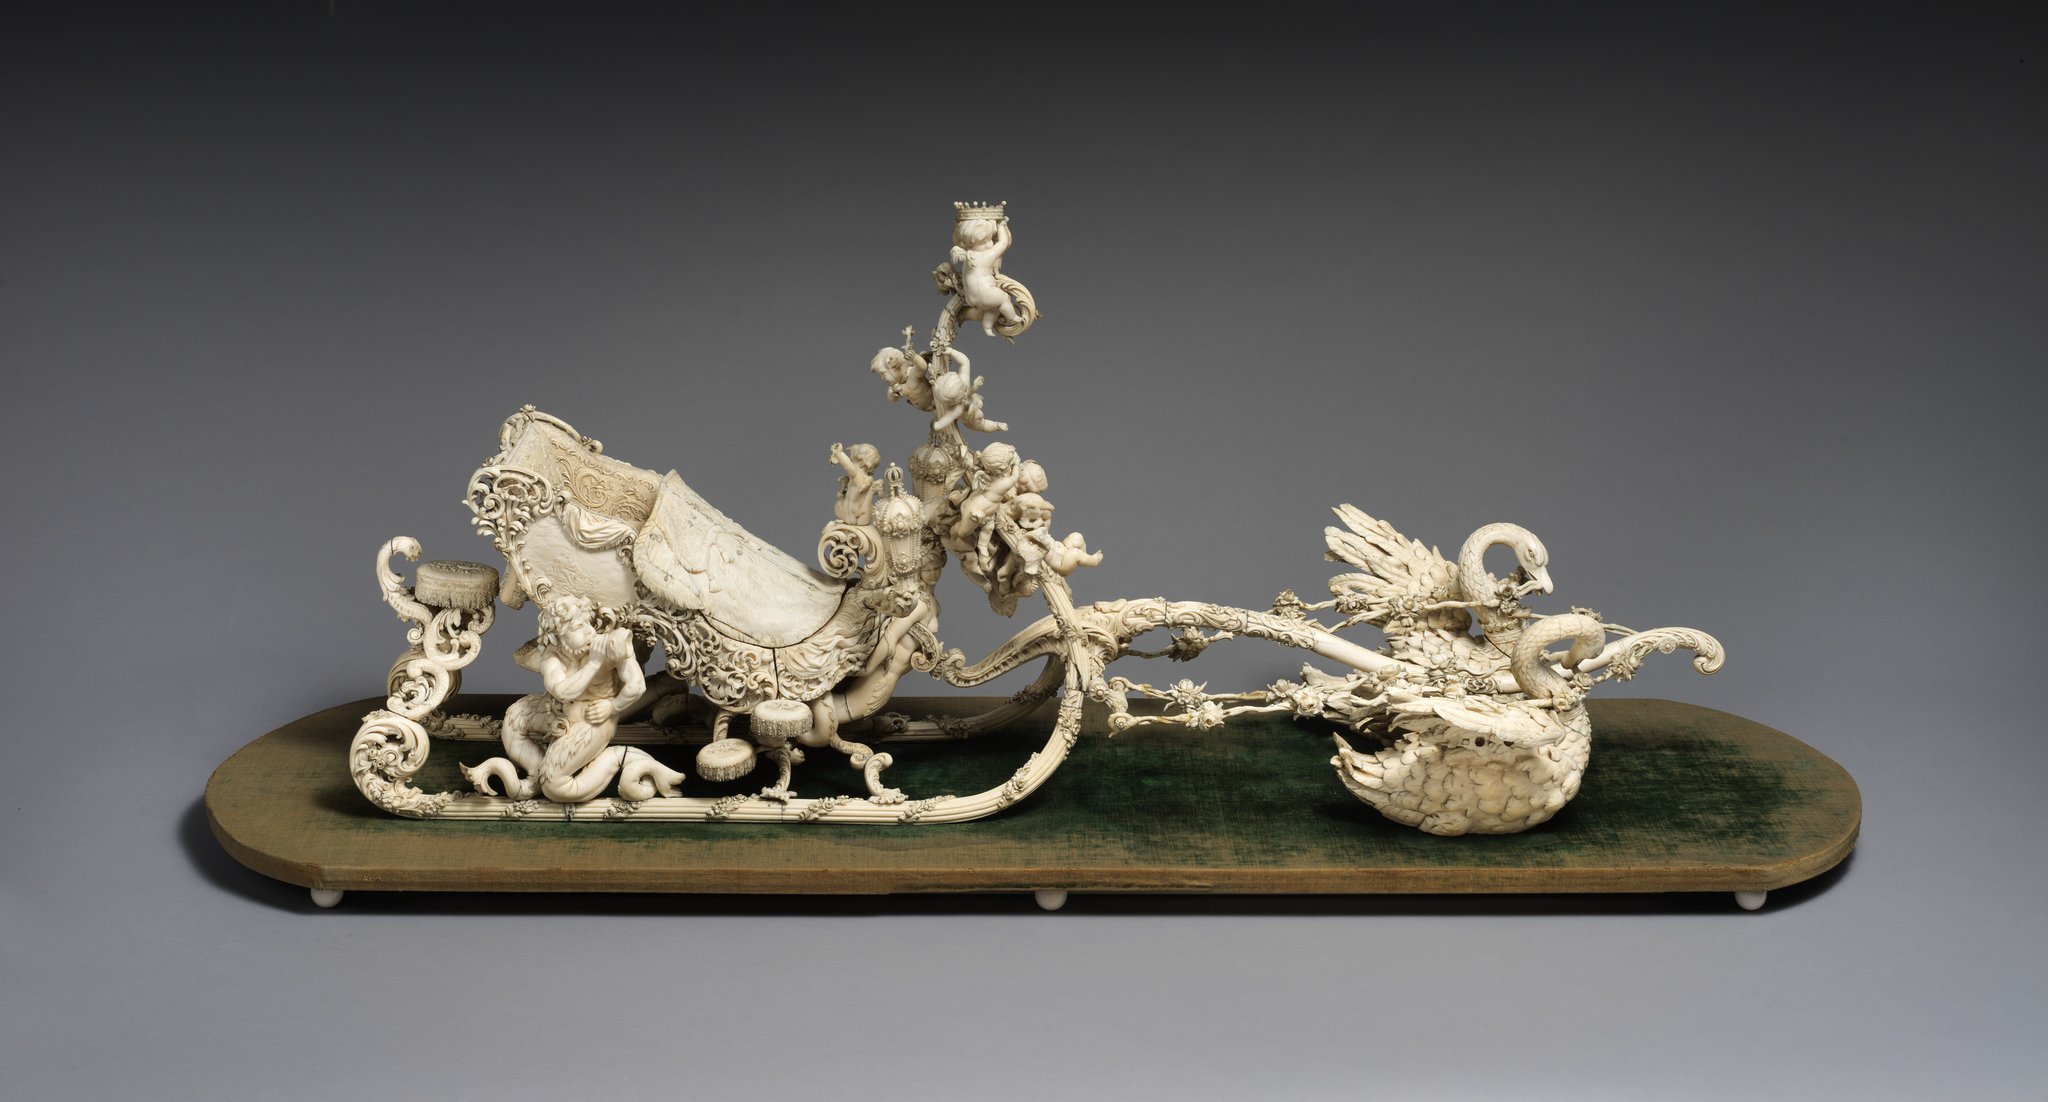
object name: model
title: Model of King Ludwig II of Bavaria's Neo-Rococo Sleigh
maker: franz seitz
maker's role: designer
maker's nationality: german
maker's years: 1817-1883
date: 1872-1880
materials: ivory, silk, velvet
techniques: carving, engraving